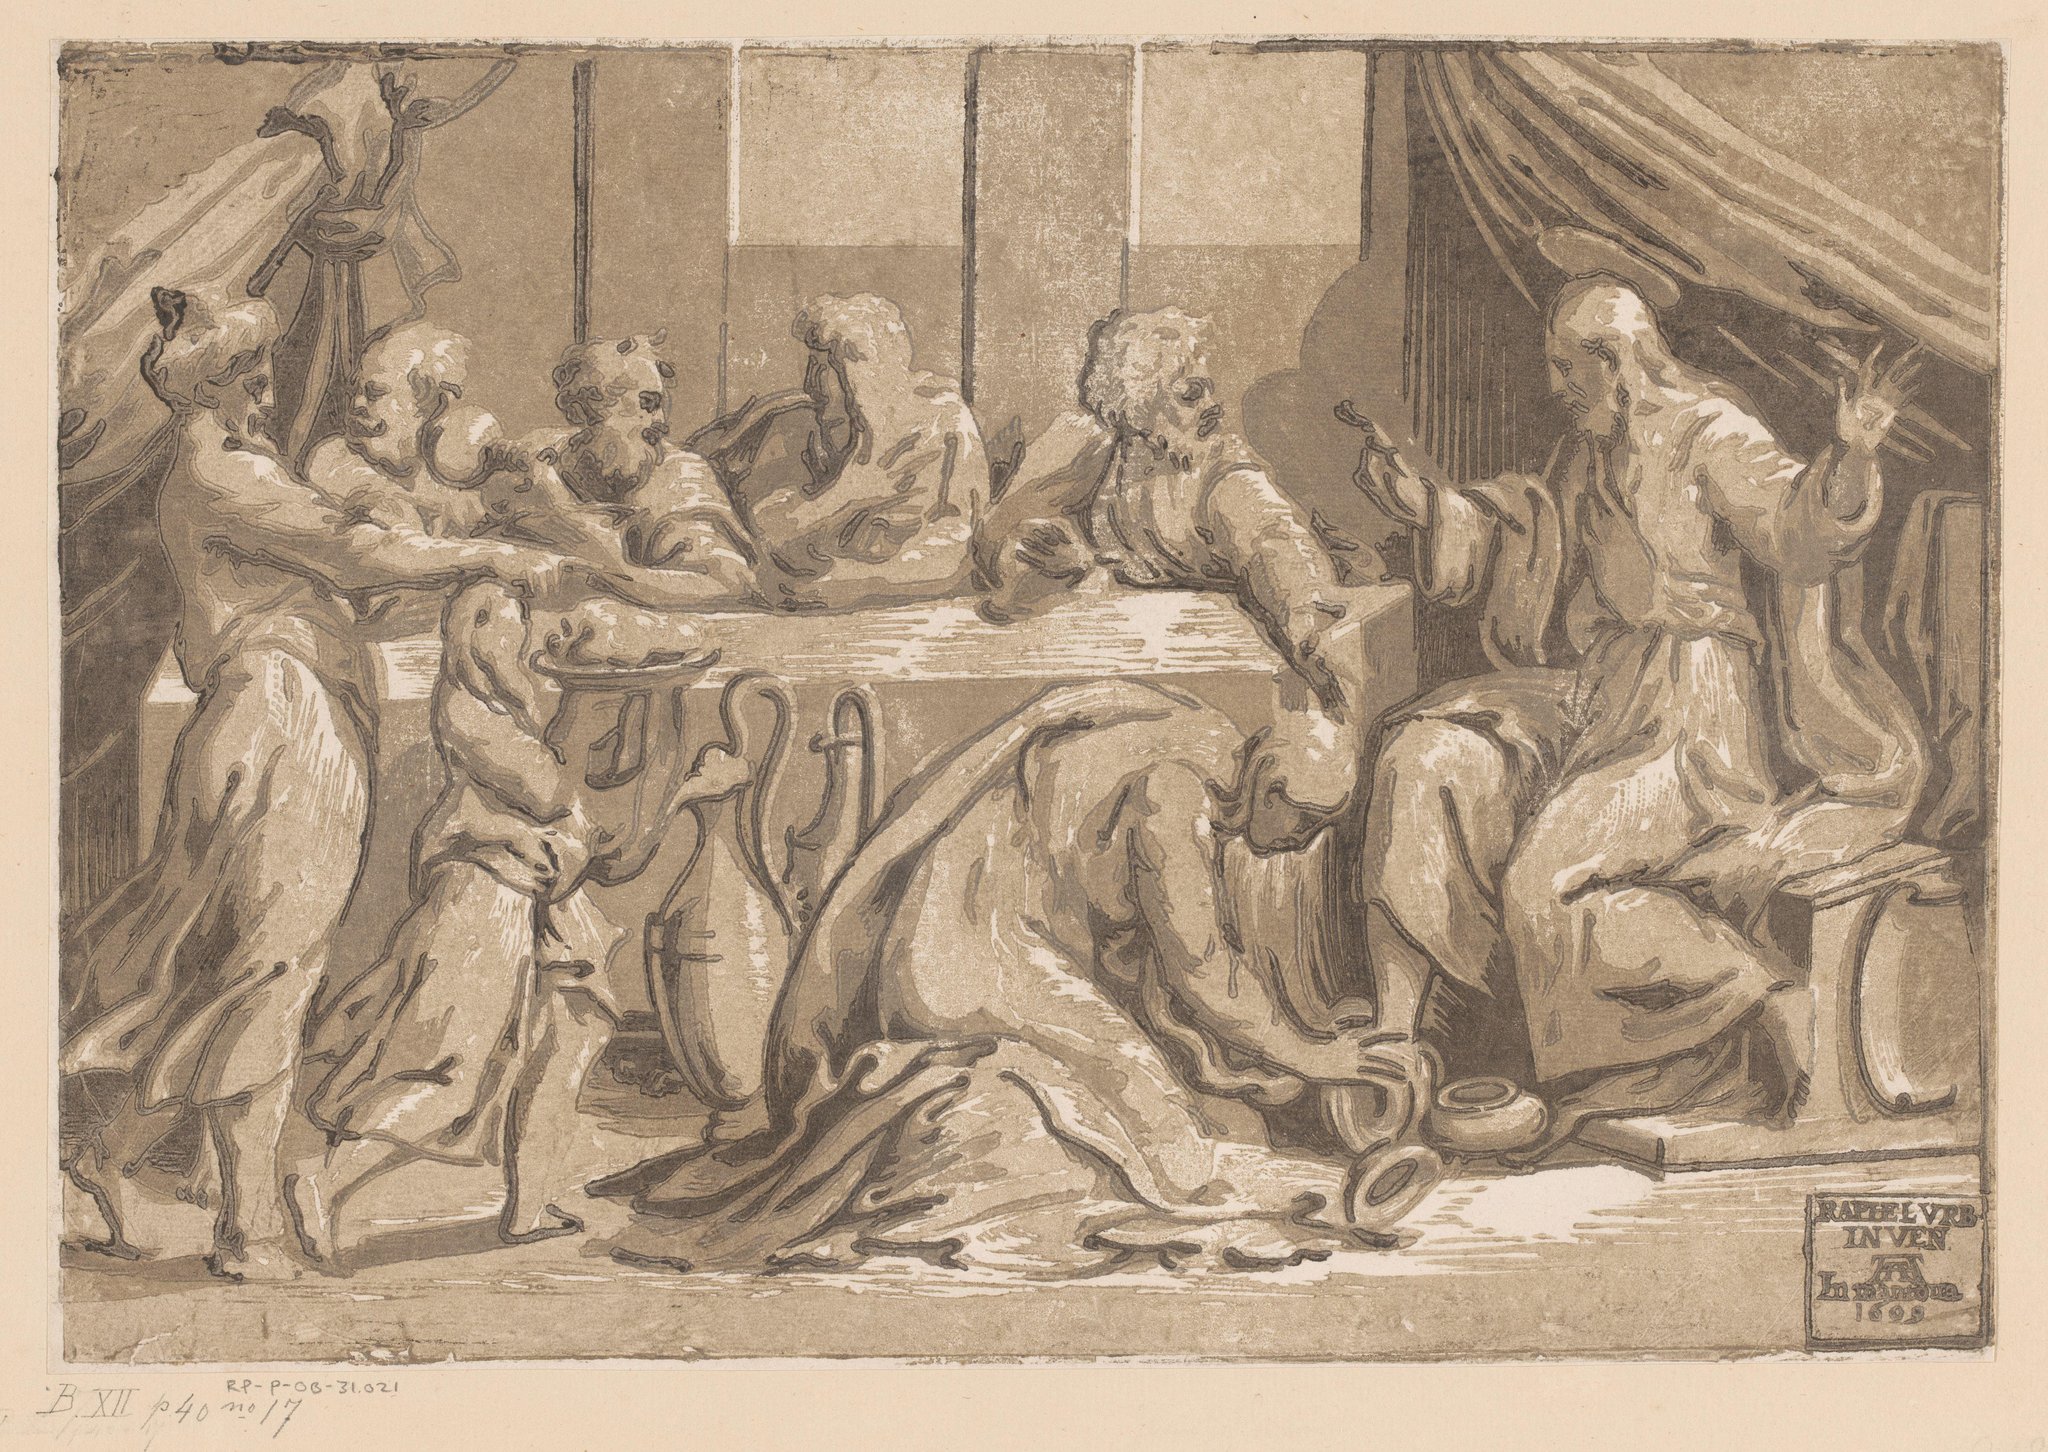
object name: print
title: Christus gezalfd door Maria Magdalena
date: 1609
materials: paper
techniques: woodcut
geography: italy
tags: christ's feet are anointed by mary (magdalene)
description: Christus zit aan tafel te eten in het huis van Simon de Farizeeër. Maria Magdalena knielt op de grond zalft zijn voeten en droogt ze met haar haren.